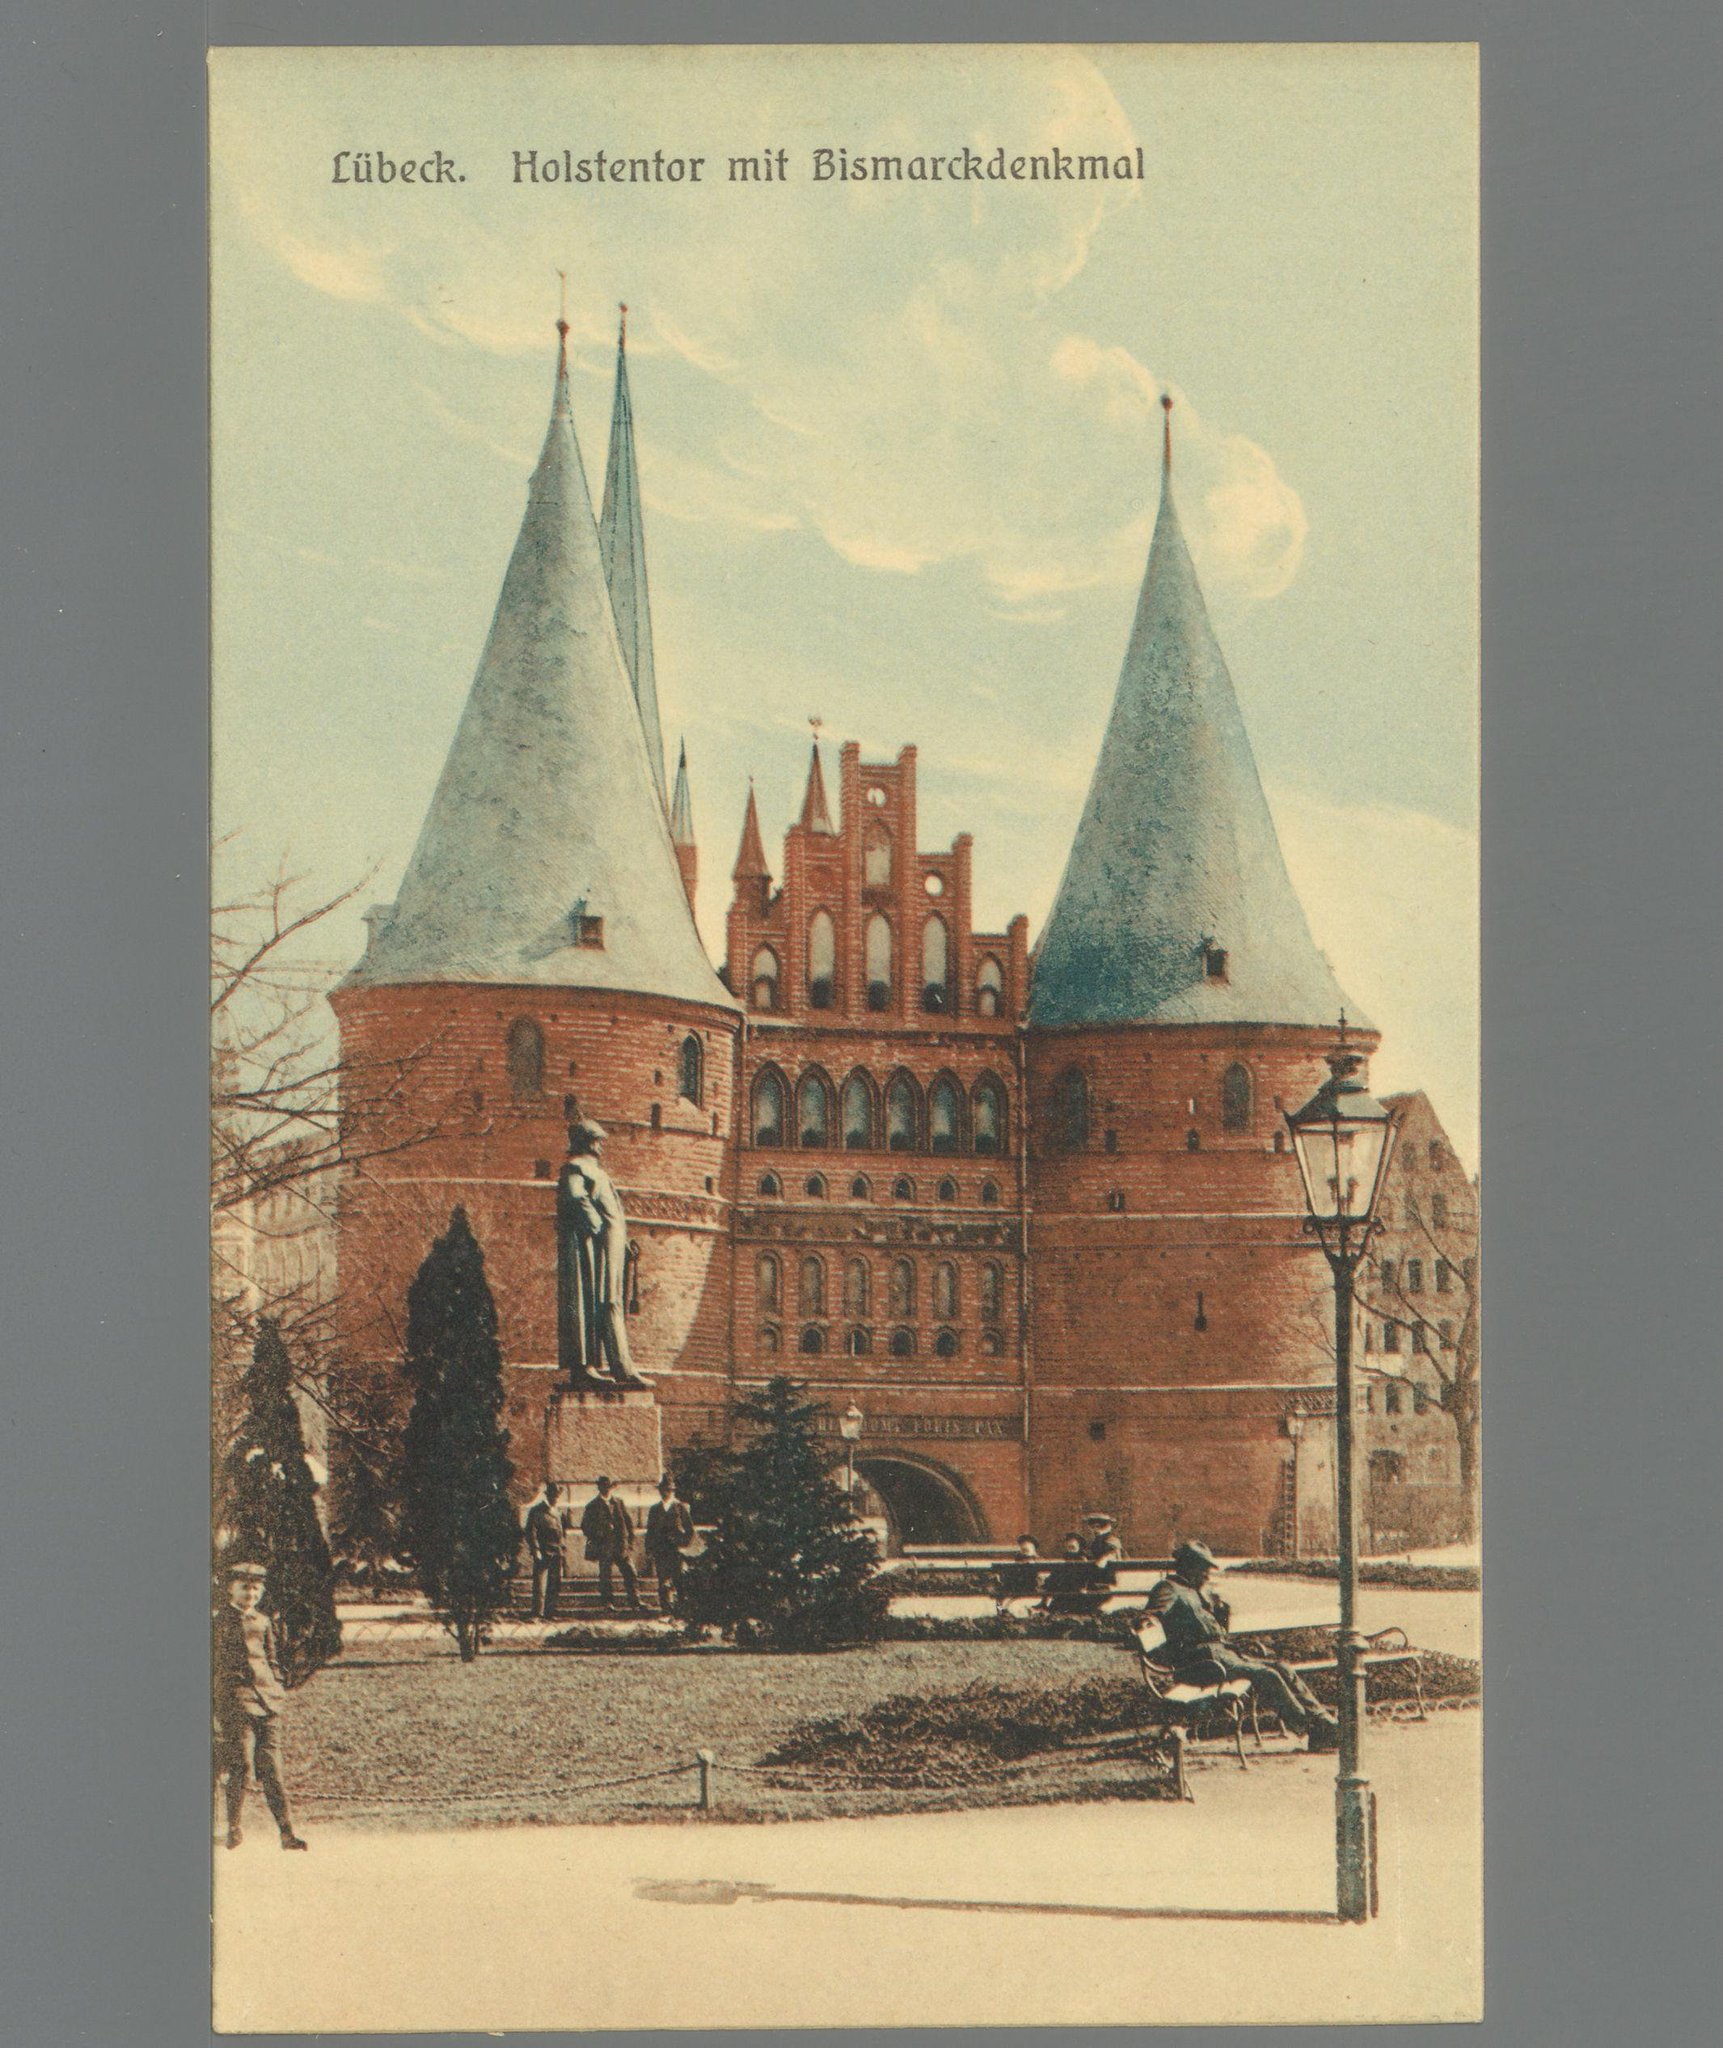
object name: photomechanical print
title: Lübeck. Holstentor mit Bismarckdenkmal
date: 1905-1930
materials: cardboard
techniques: collotype process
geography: lübeck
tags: city-gate